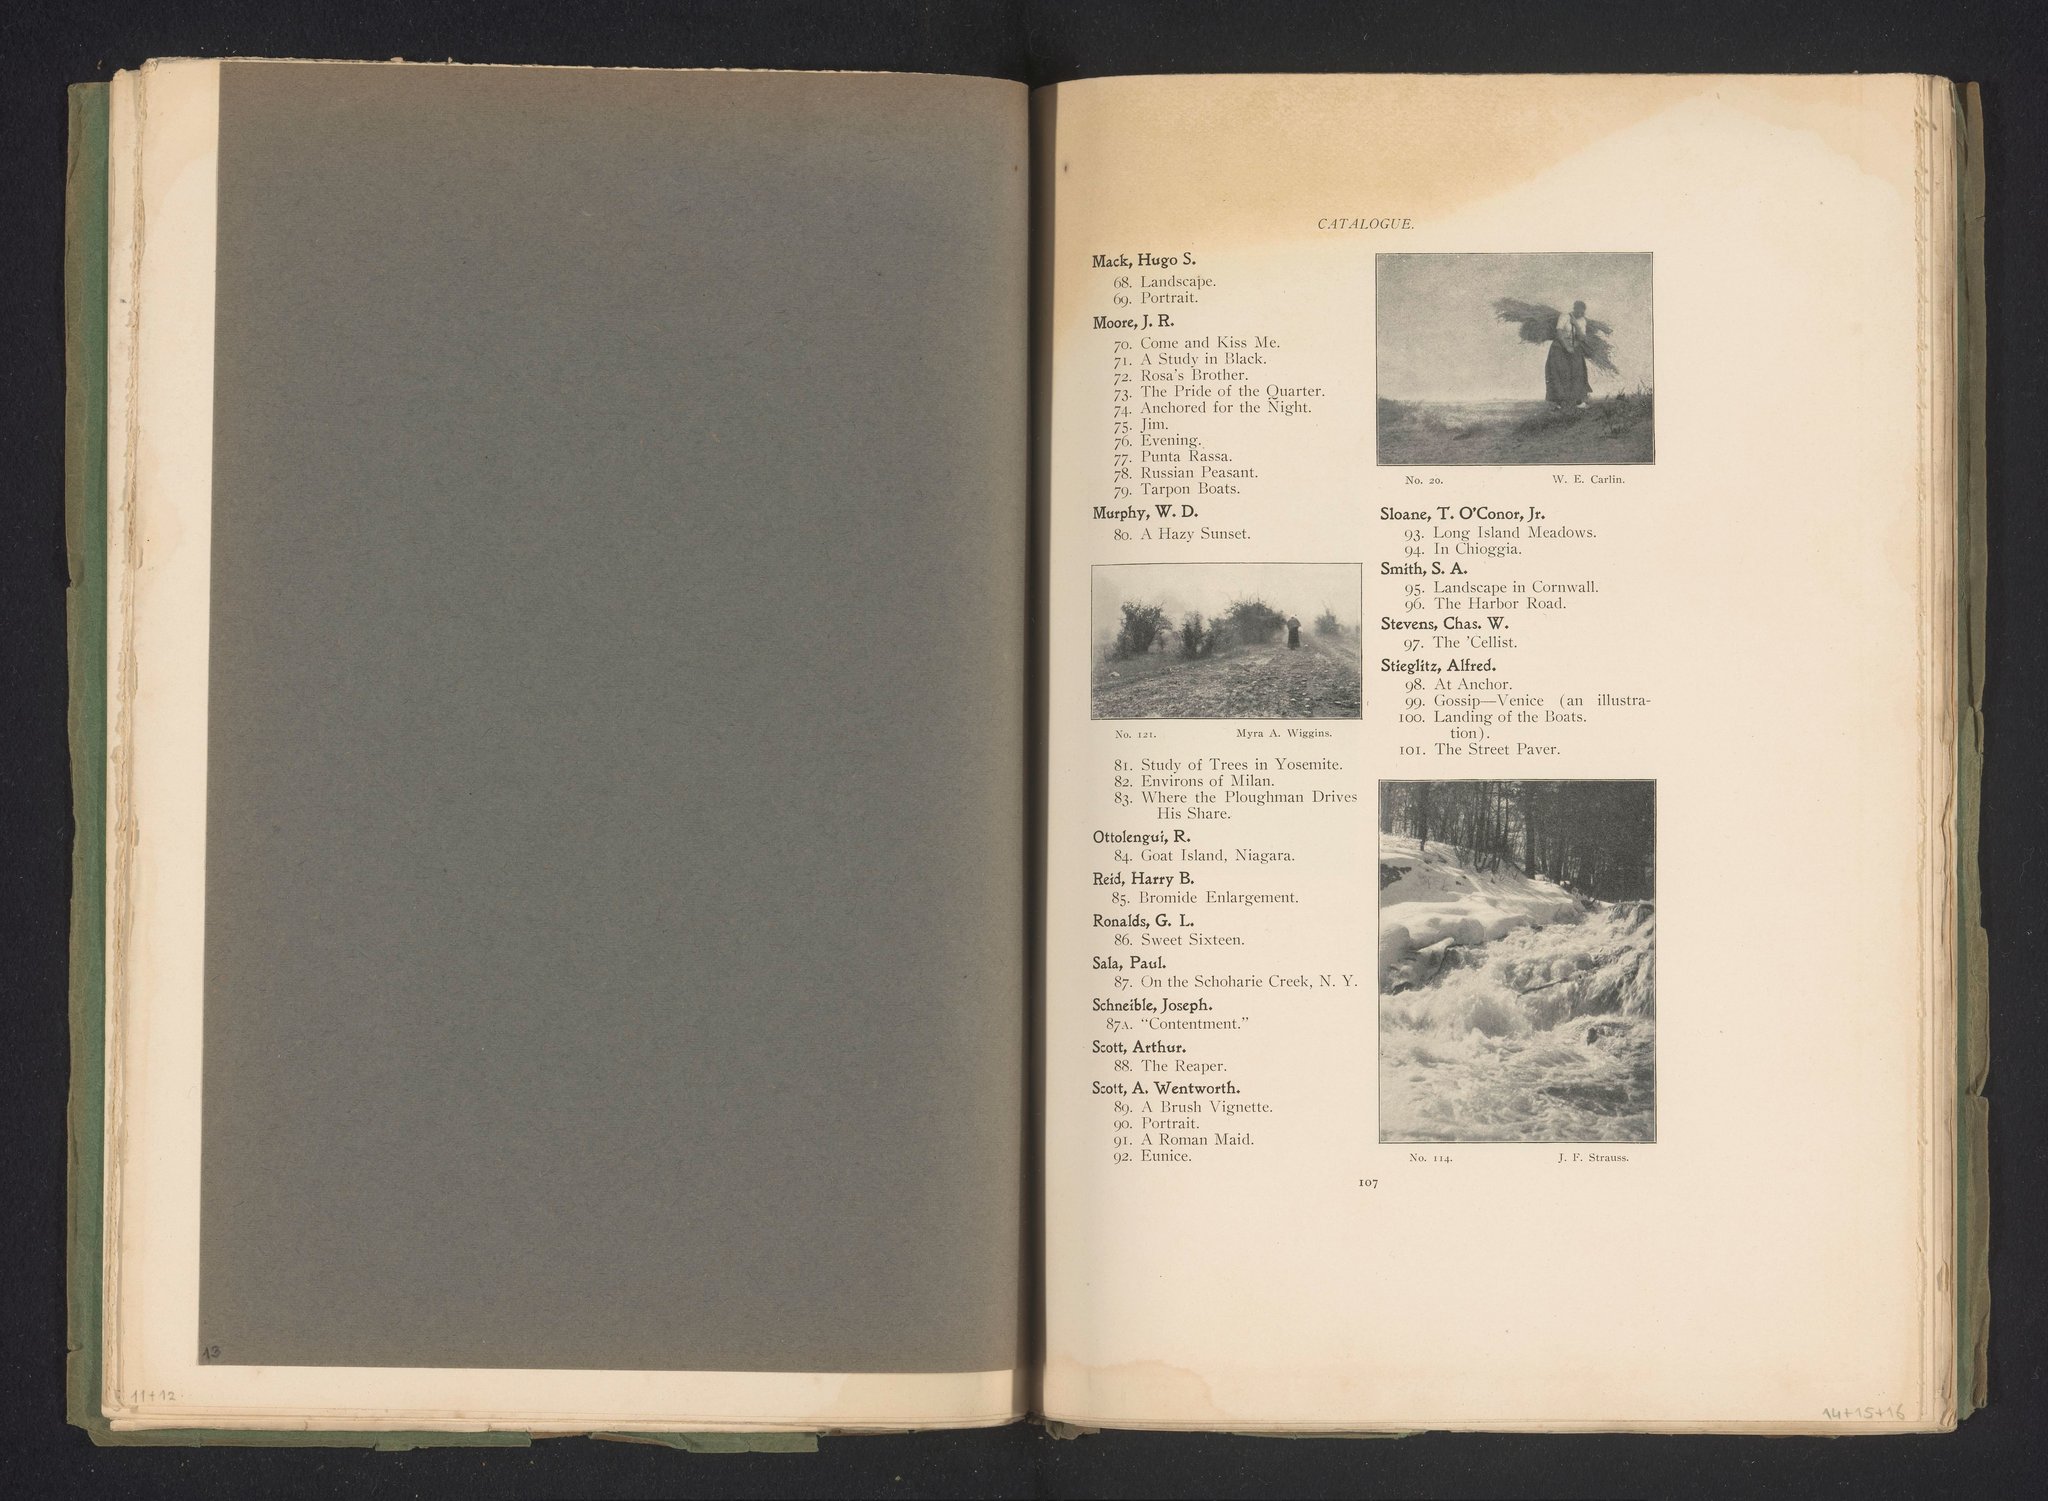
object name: photomechanical print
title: Stroomversnelling in de sneeuw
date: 1895-1900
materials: paper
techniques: autotype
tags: rapids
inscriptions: number: ‘No. 114’